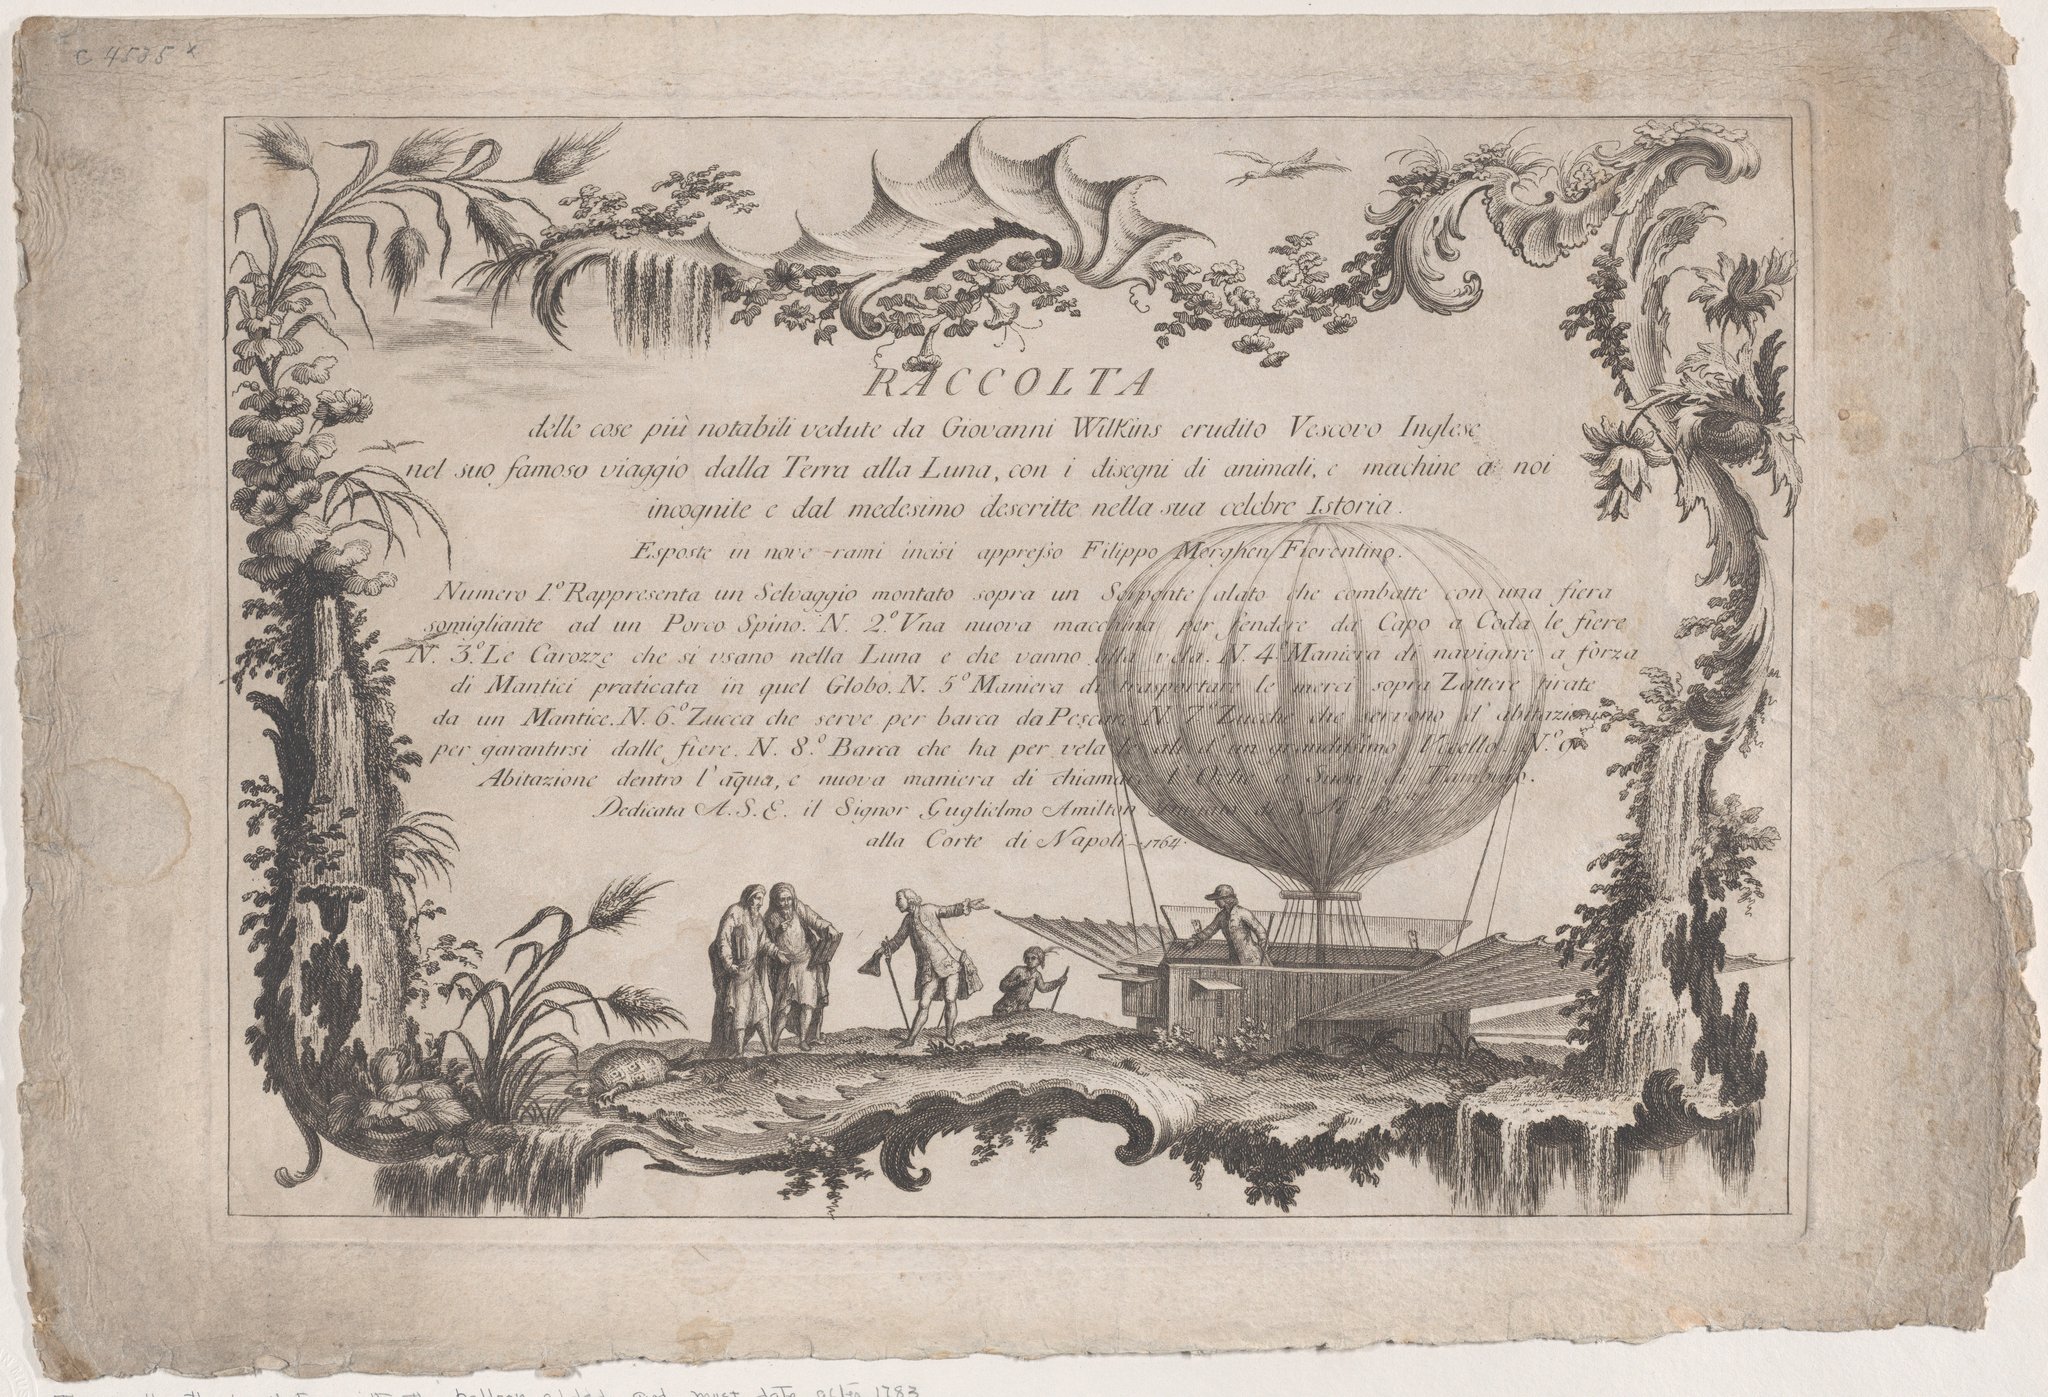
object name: print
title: Title plate from 'The collection of the most notable things seen by John Wilkins, erudite English bishop, on his famous trip from the Earth to the Moon... (Raccolta delle cose più notabili Vedute da Giovanni Wilkins erudito Vescove Inglese nel suo famoso viaggio dalla Terra alla Luna...)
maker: filippo morghen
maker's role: artist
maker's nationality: italian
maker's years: 1730-1807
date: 1783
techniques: etching